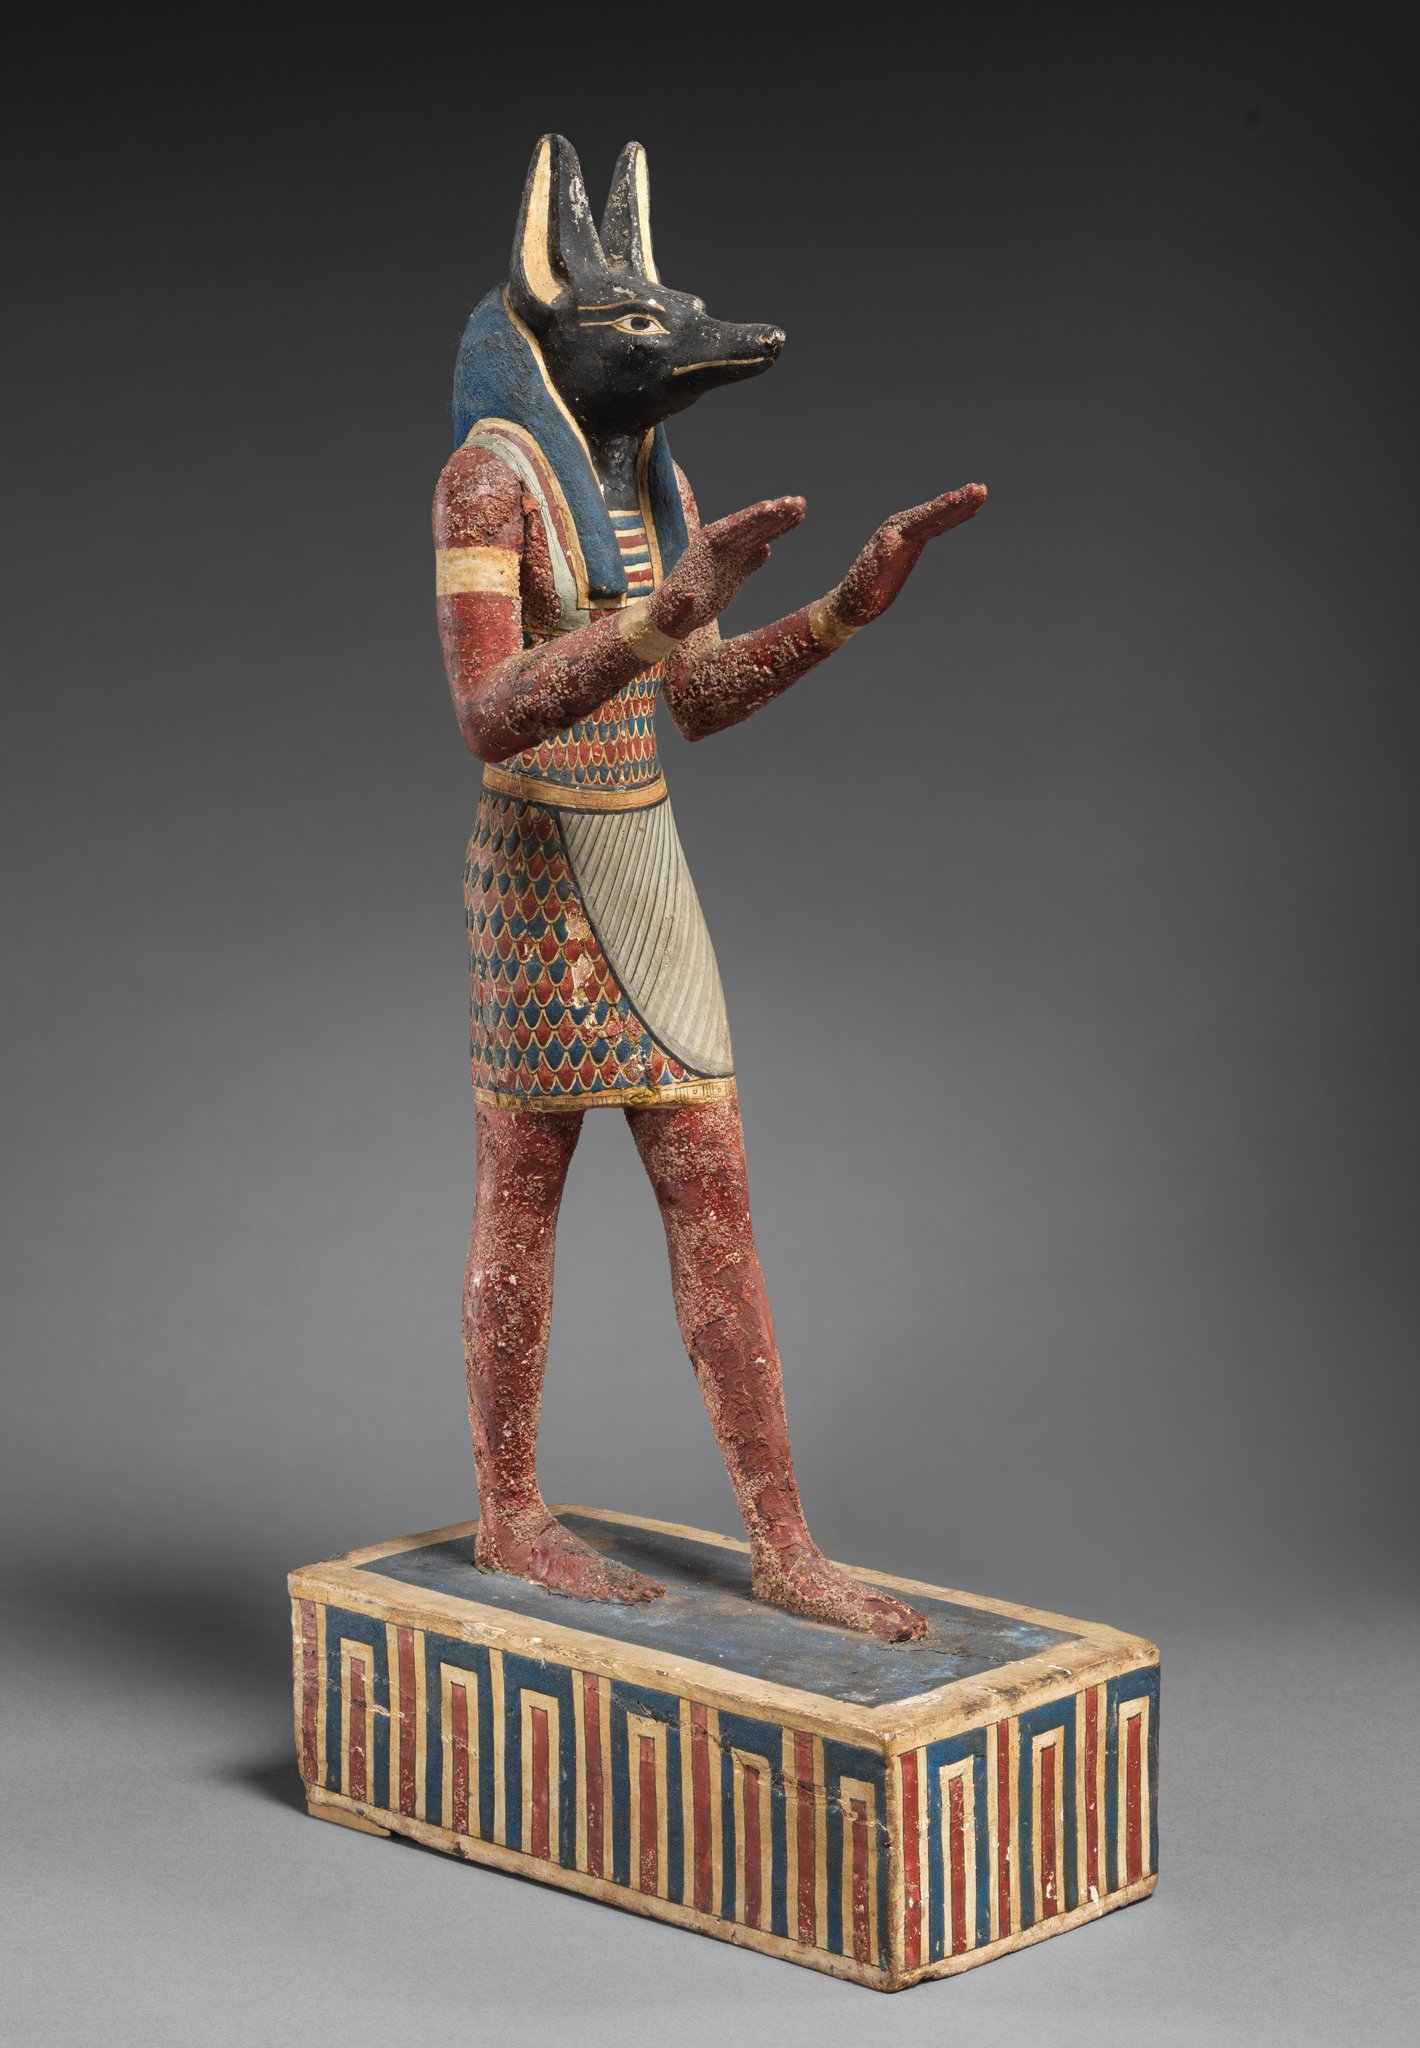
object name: anubis, jackal headed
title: Statuette of a canid-headed god, probably Anubis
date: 332-330 BCE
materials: wood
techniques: painting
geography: egypt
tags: anubis